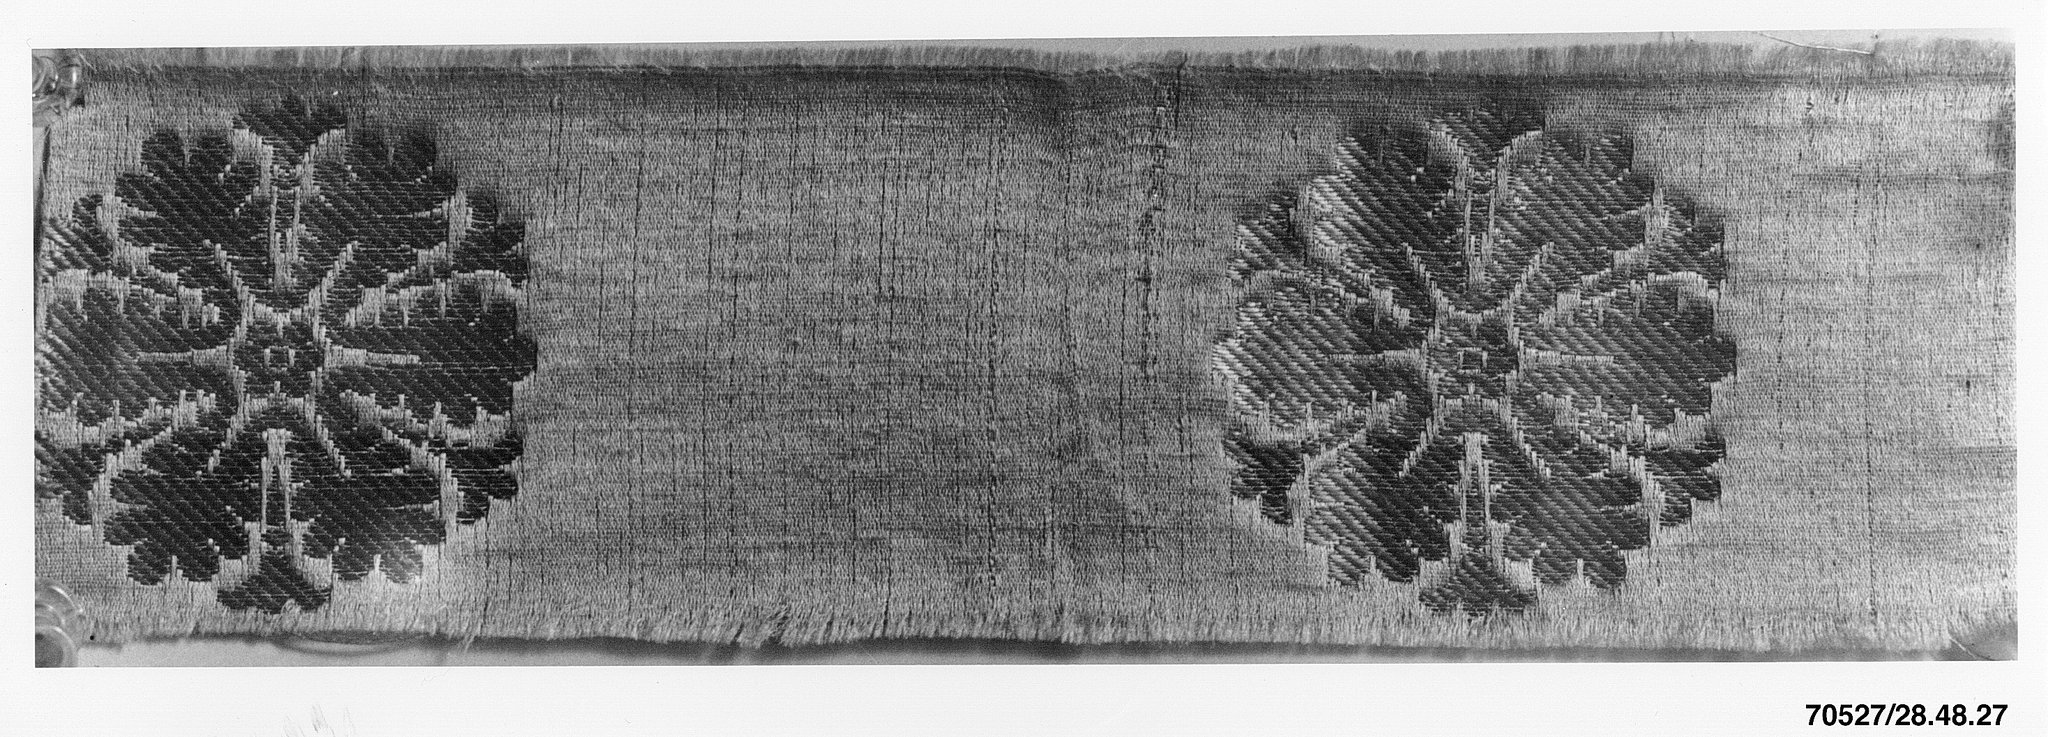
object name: piece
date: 1801-1900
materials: linen, silk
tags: flowers